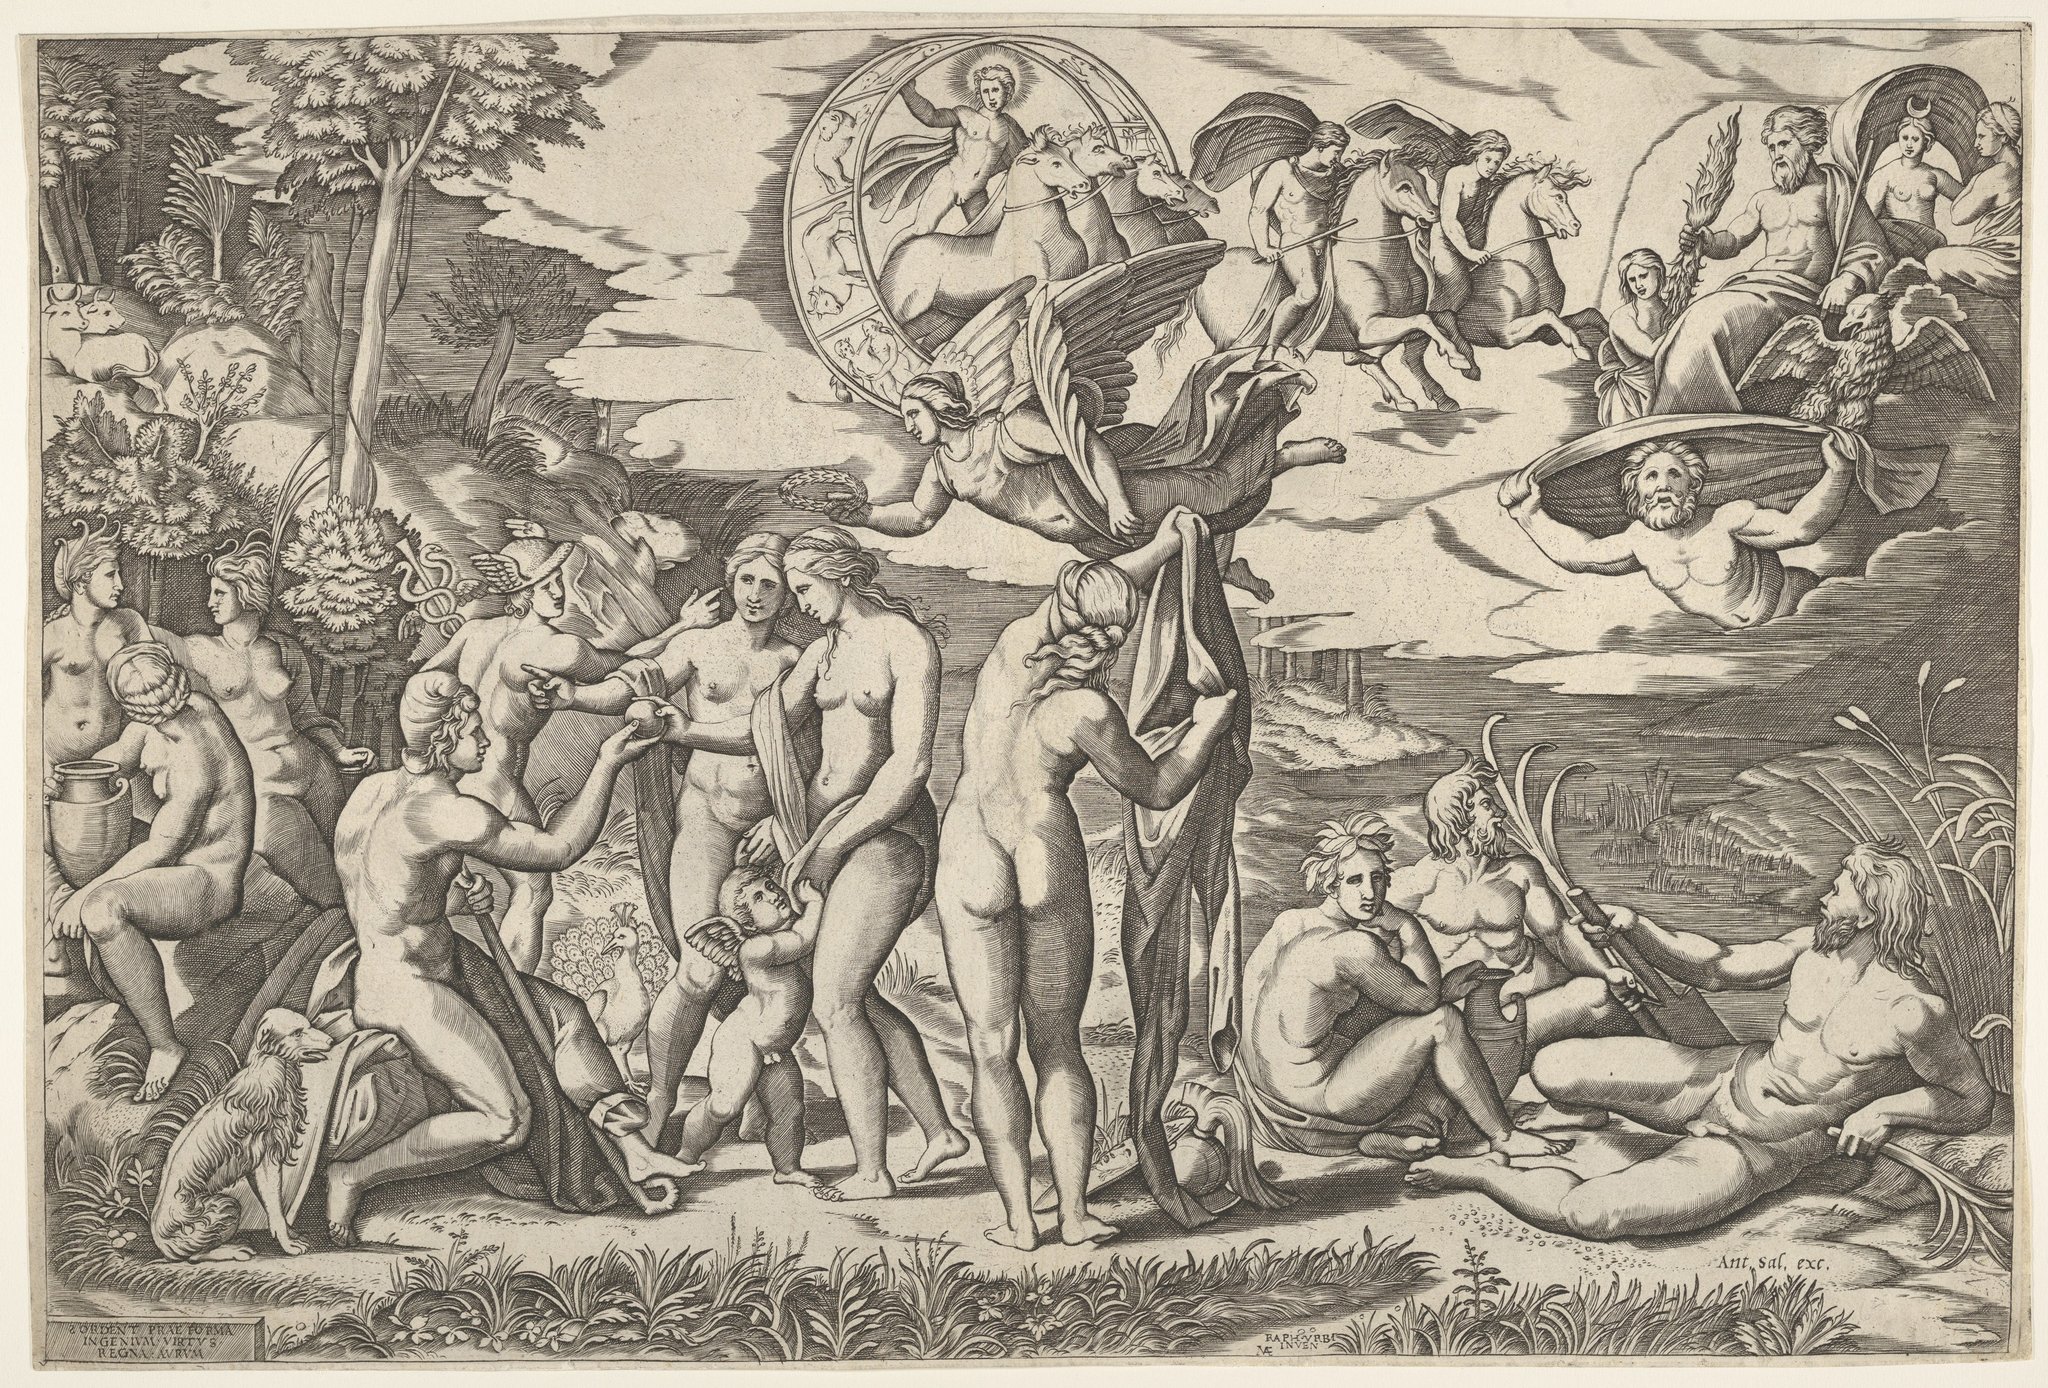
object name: print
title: Judgment of Paris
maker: marcantonio raimondi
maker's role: artist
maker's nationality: italian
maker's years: 1475-1534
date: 1520-1550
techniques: engraving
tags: juno,minerva,venus,horses